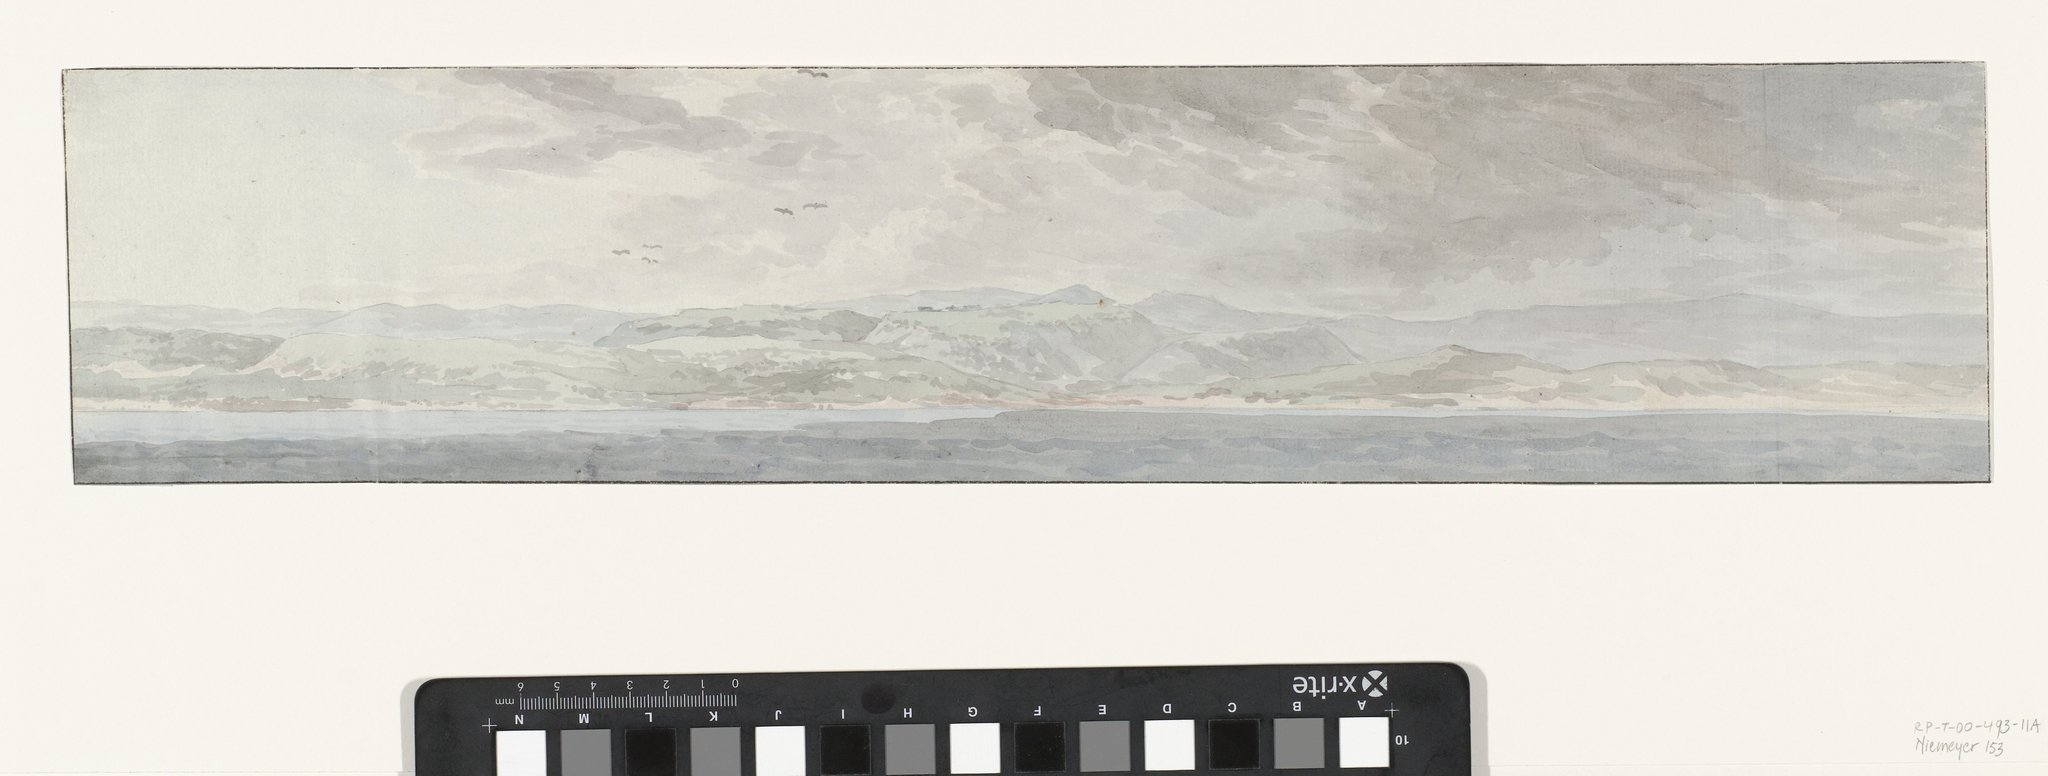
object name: watercolor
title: Gezicht op kust van Strongoli ten zuiden van de Cap delle Alice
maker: louis ducros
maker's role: draughtsman, print maker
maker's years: 1748-1810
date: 1778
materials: chalk, paper, watercolor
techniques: brush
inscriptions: number: ‘No 120 Vue de la côte de Strongoli, au midi du cap delle Alice’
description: Tekening uit het album 'Voyage en Italie, en Sicile et à Malte', 1778.